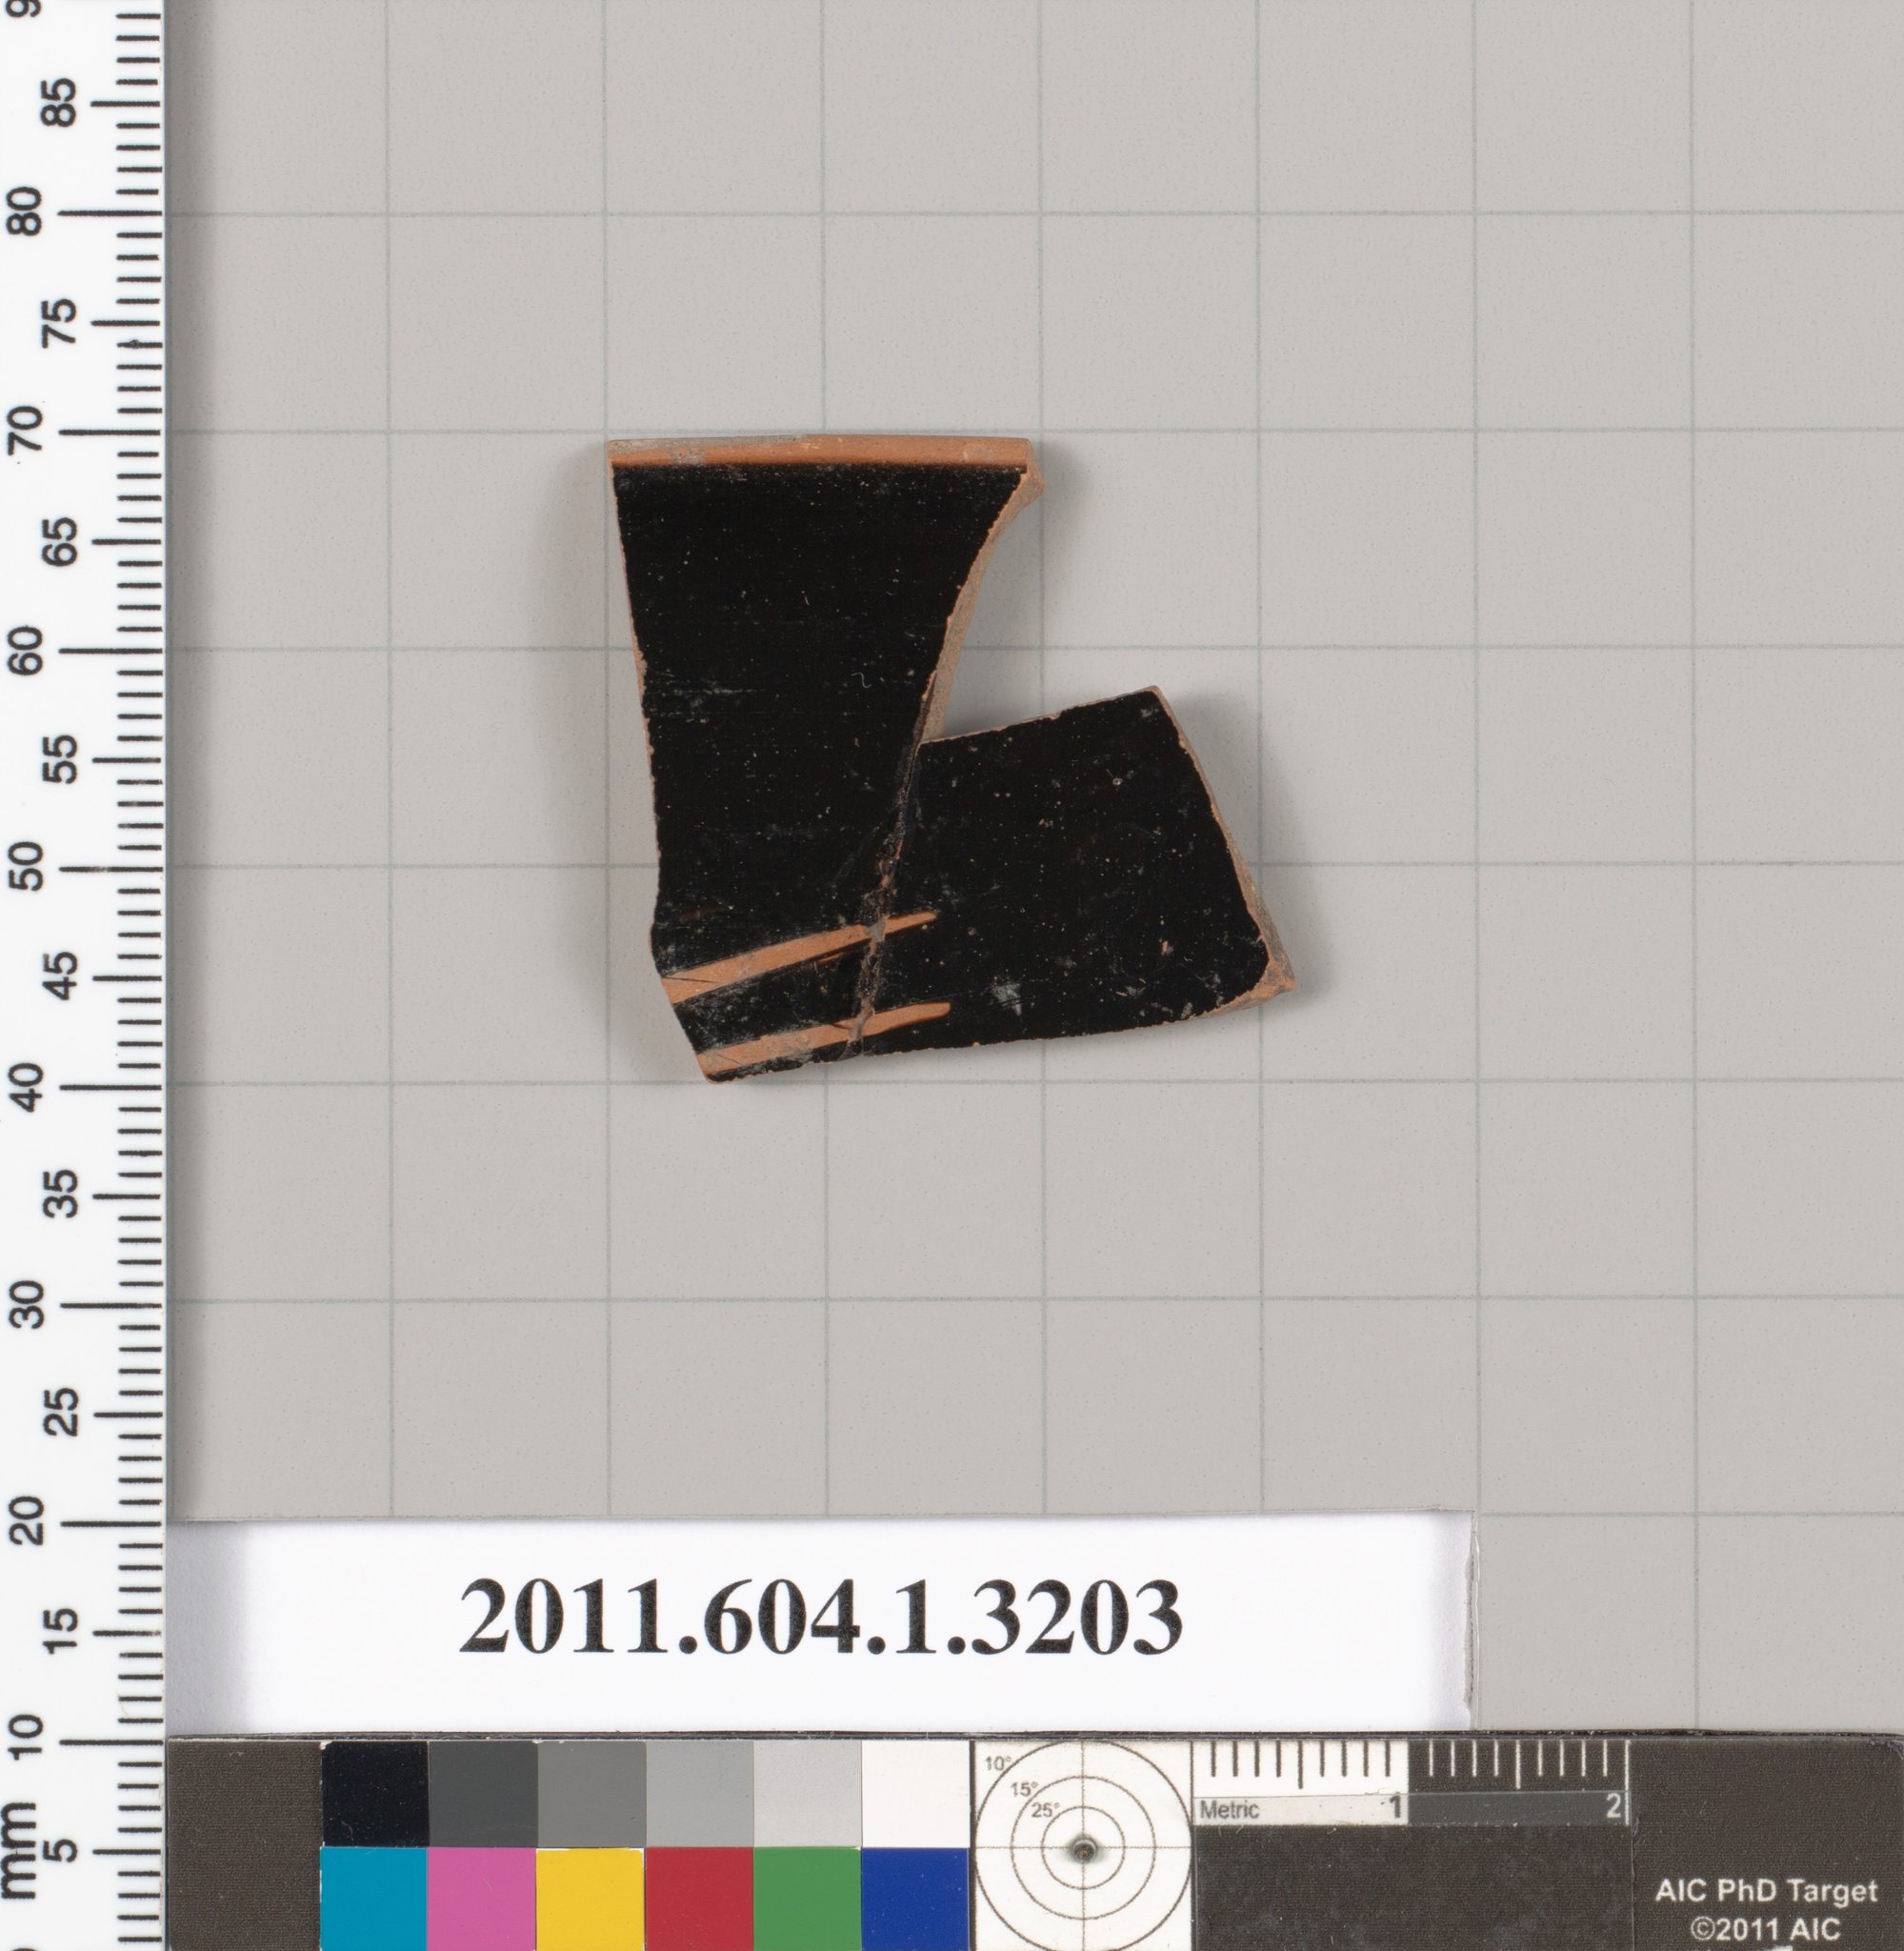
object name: kylix fragment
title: Terracotta rim fragment of a kylix (drinking cup)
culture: greek, attic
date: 520-490 BCE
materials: terracotta